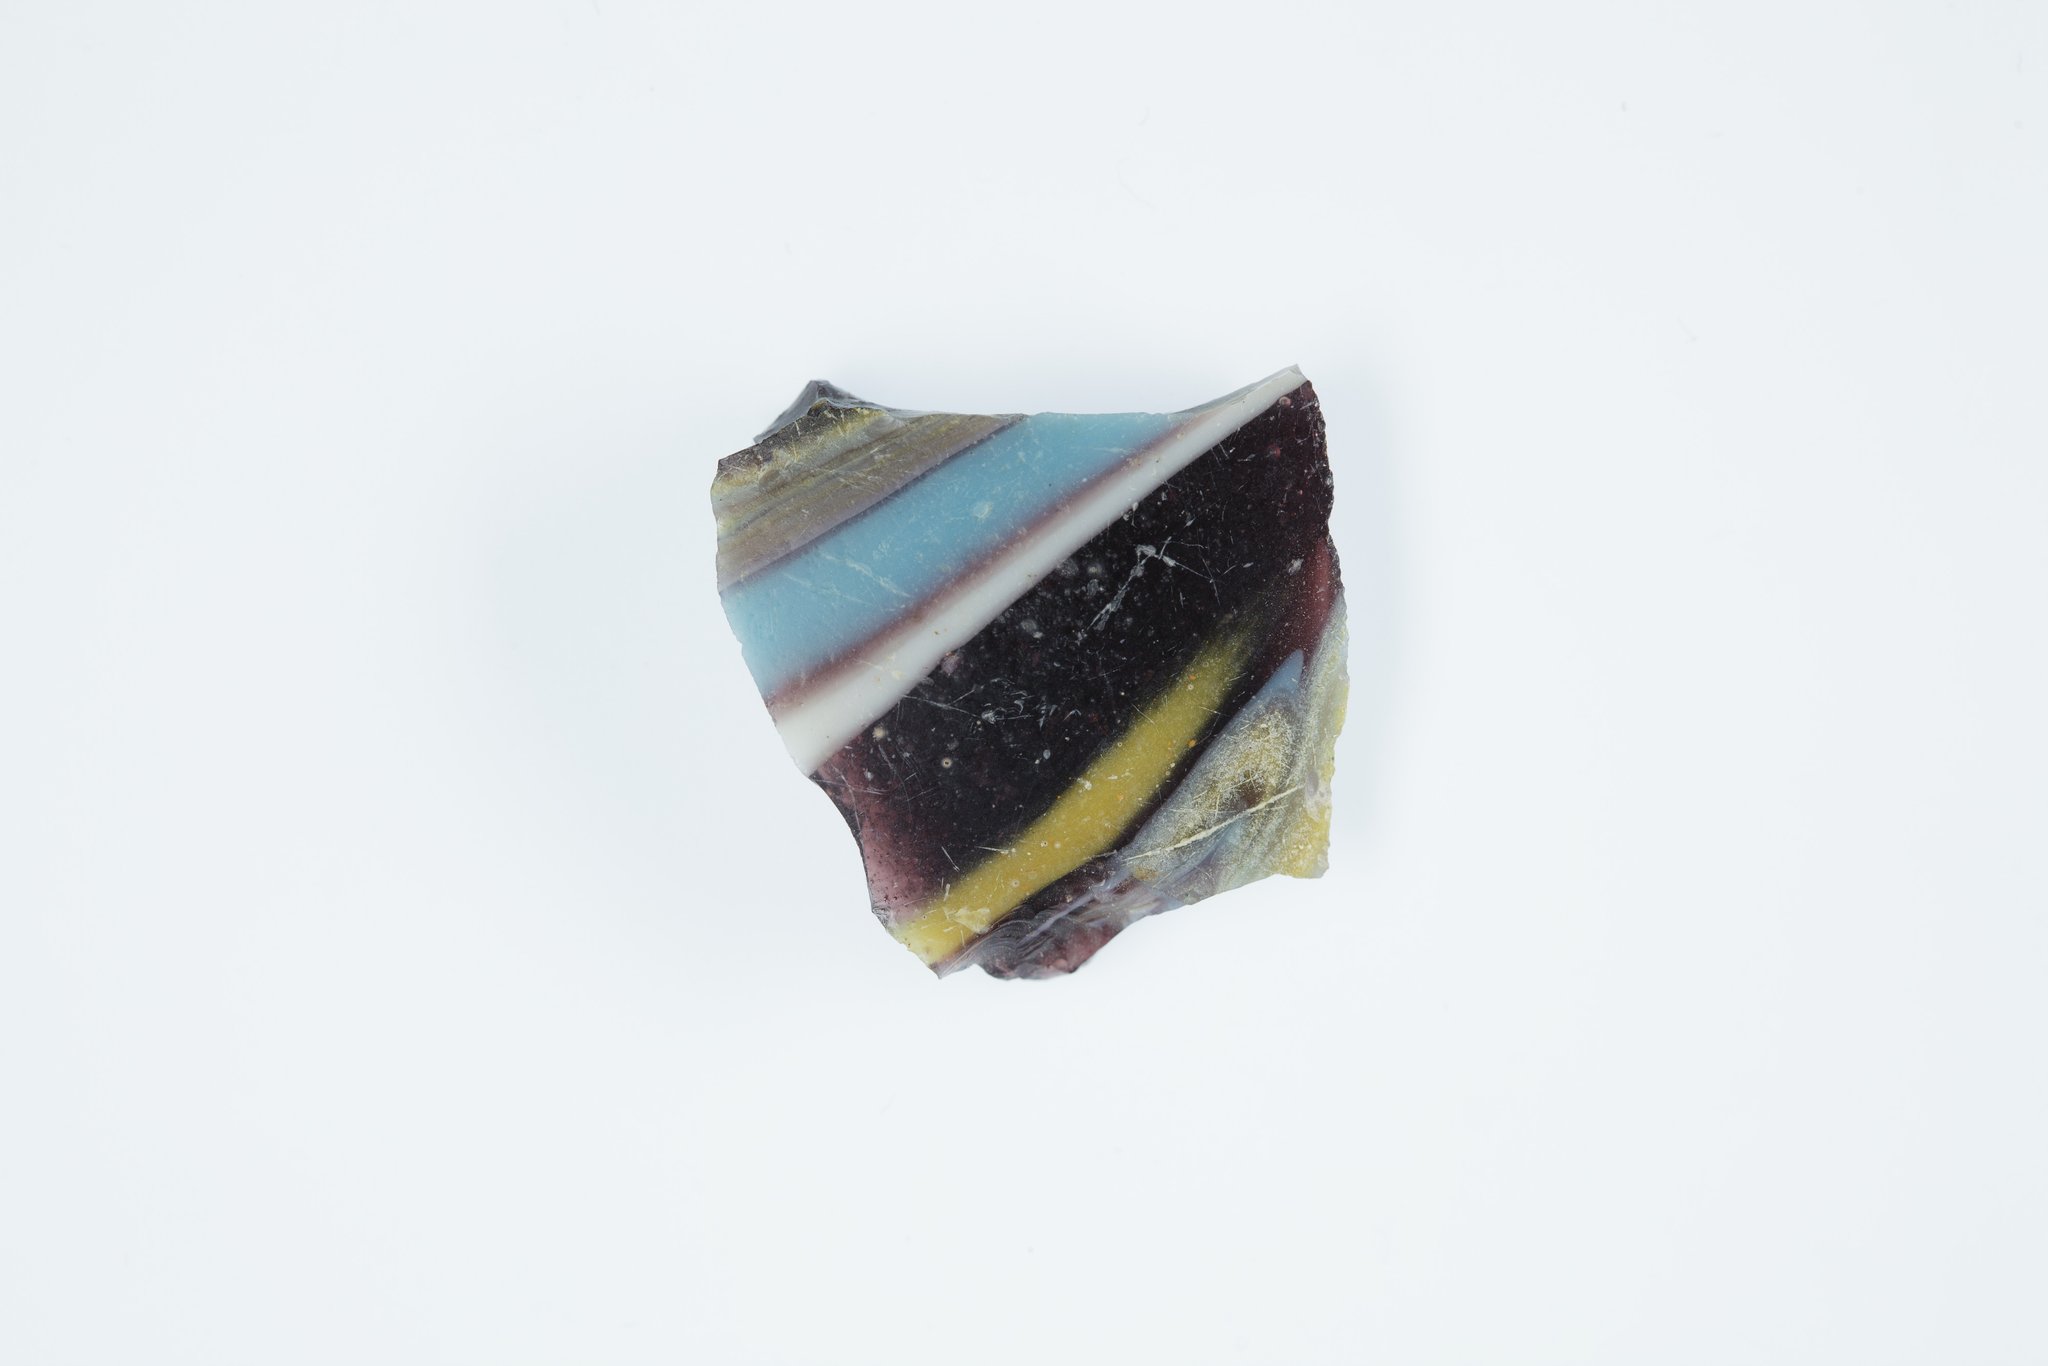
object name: vessel fragment, marbled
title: Fragment from Thick Walled Marbled Vessel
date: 1427-1400 BCE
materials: glass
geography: egypt